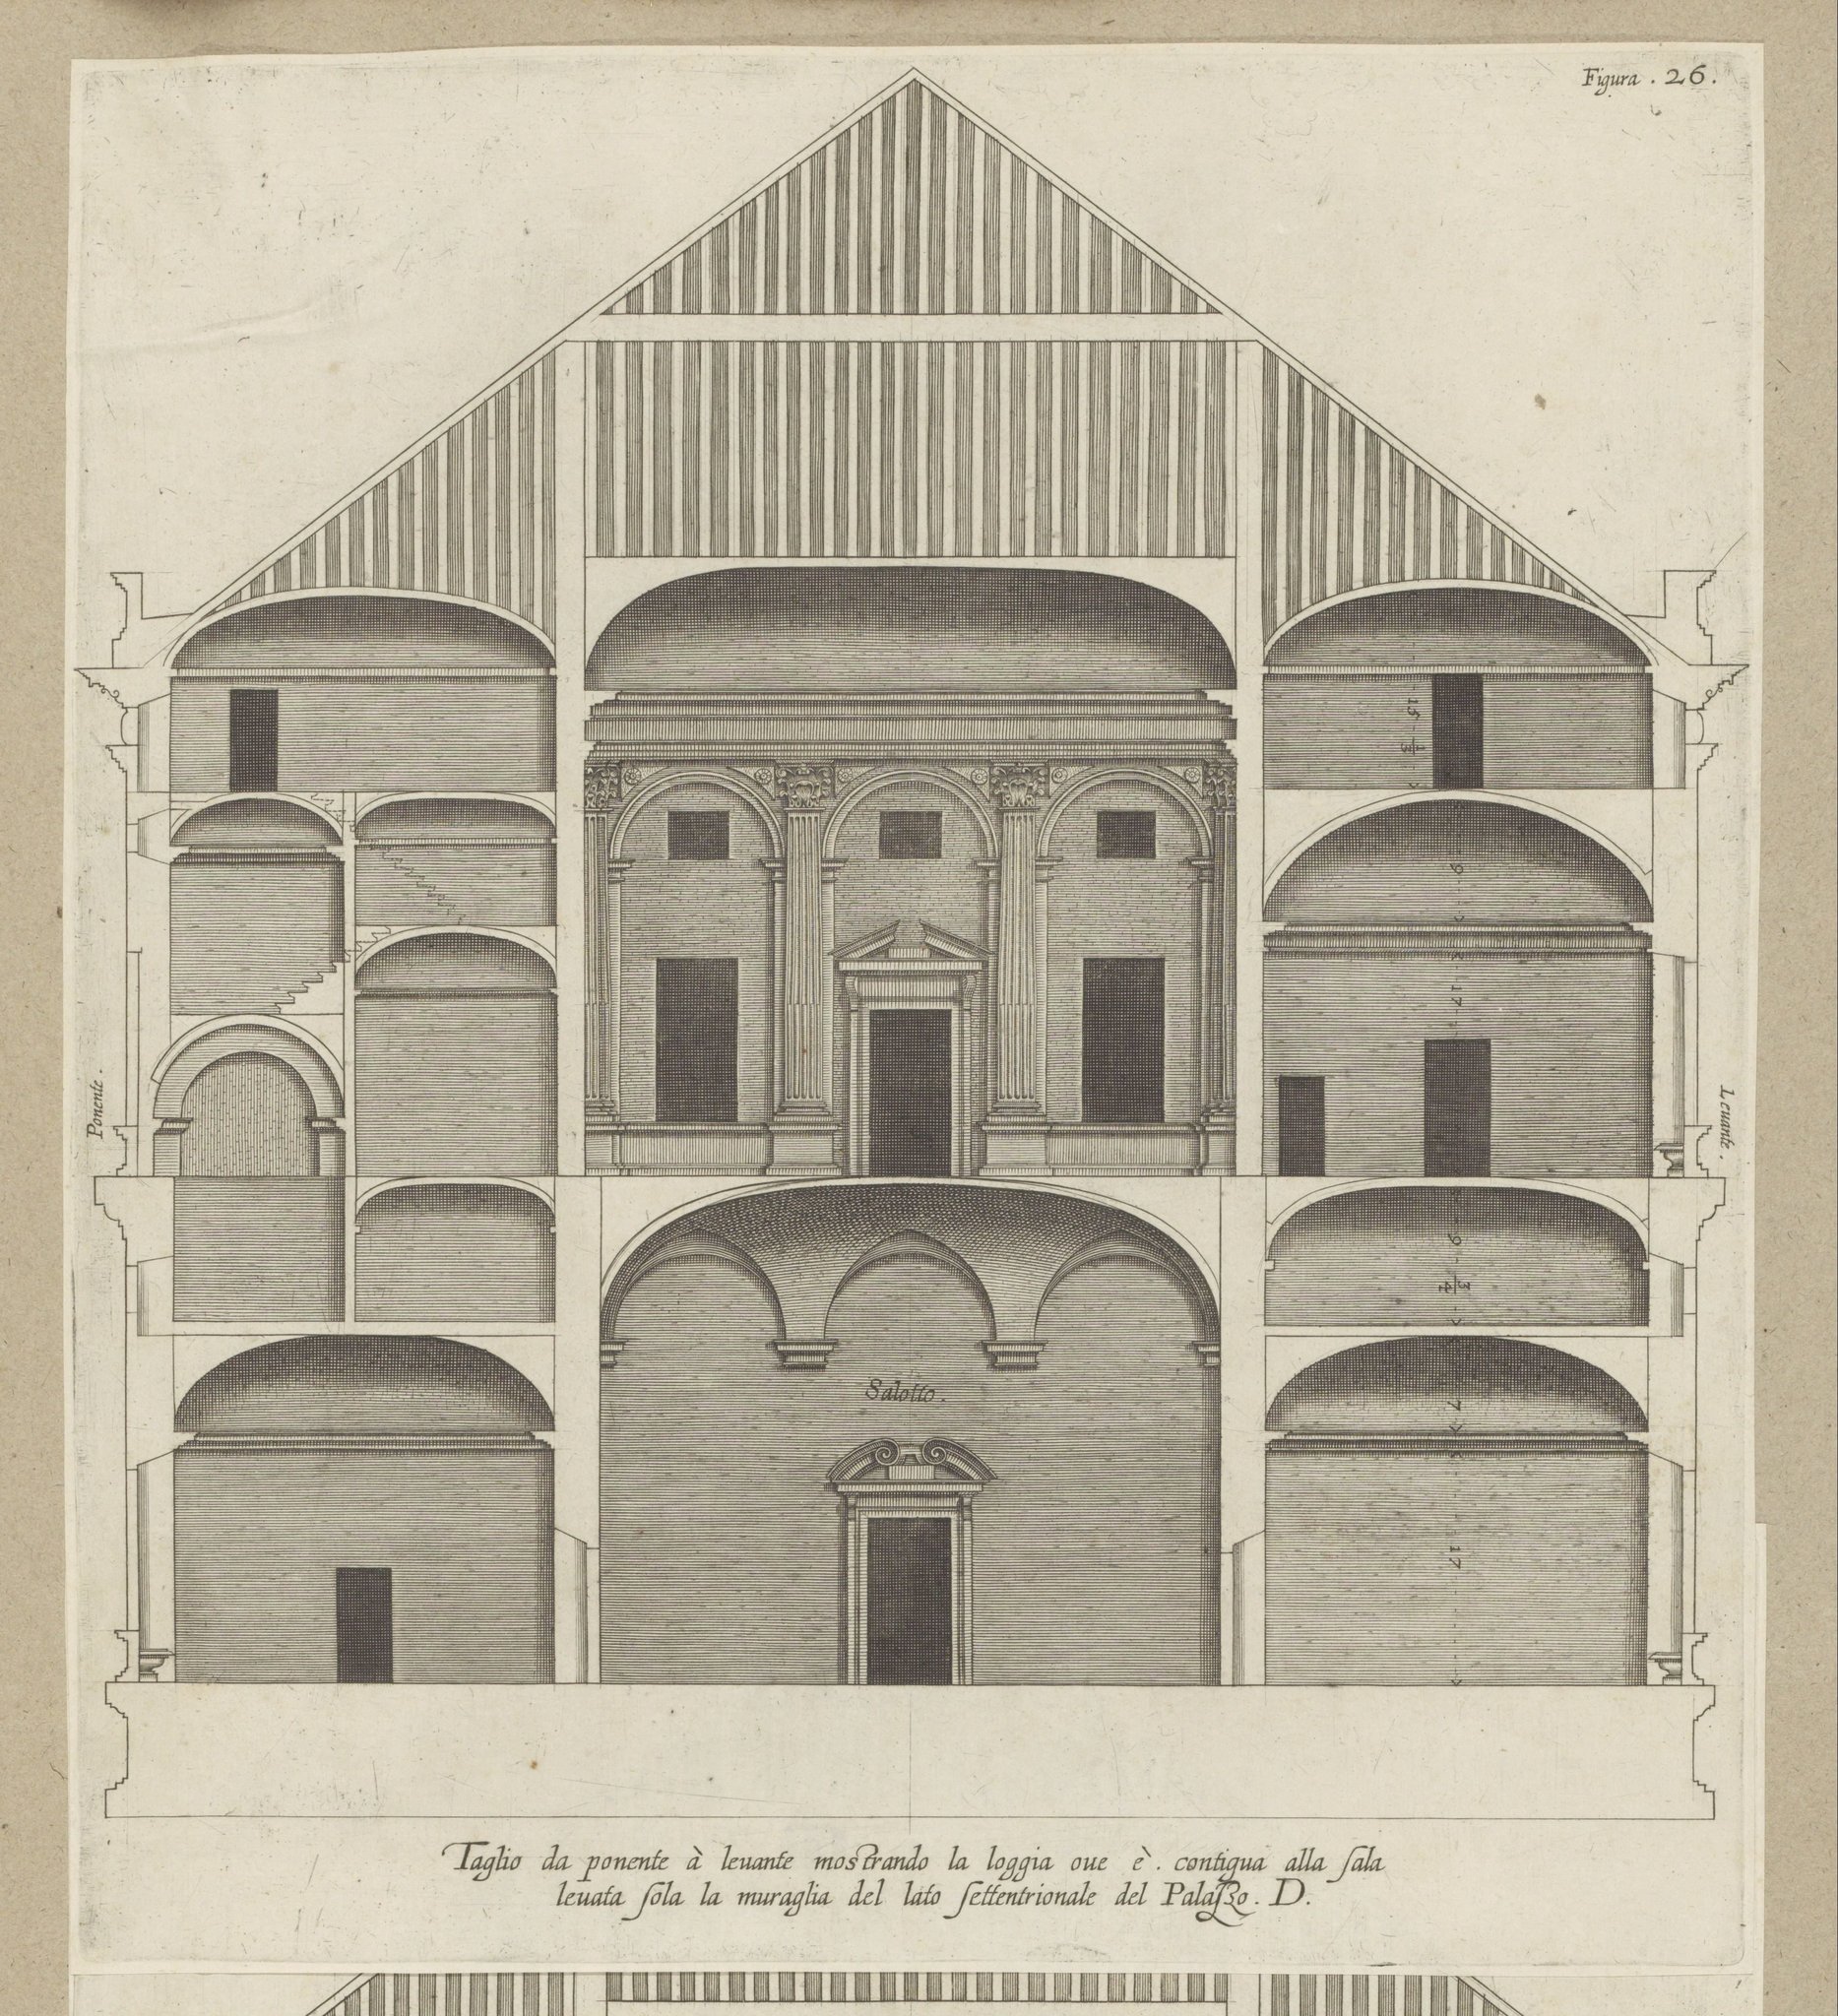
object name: album leaf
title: Langsdoorsnede van de villa Grimaldi te Genua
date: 1622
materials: paper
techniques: engraving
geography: antwerp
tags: hôtel, i.e. small palace in city - aa - civic architecture: inside, section ~ architectural design or model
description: Deze prent maakt deel uit van een album.